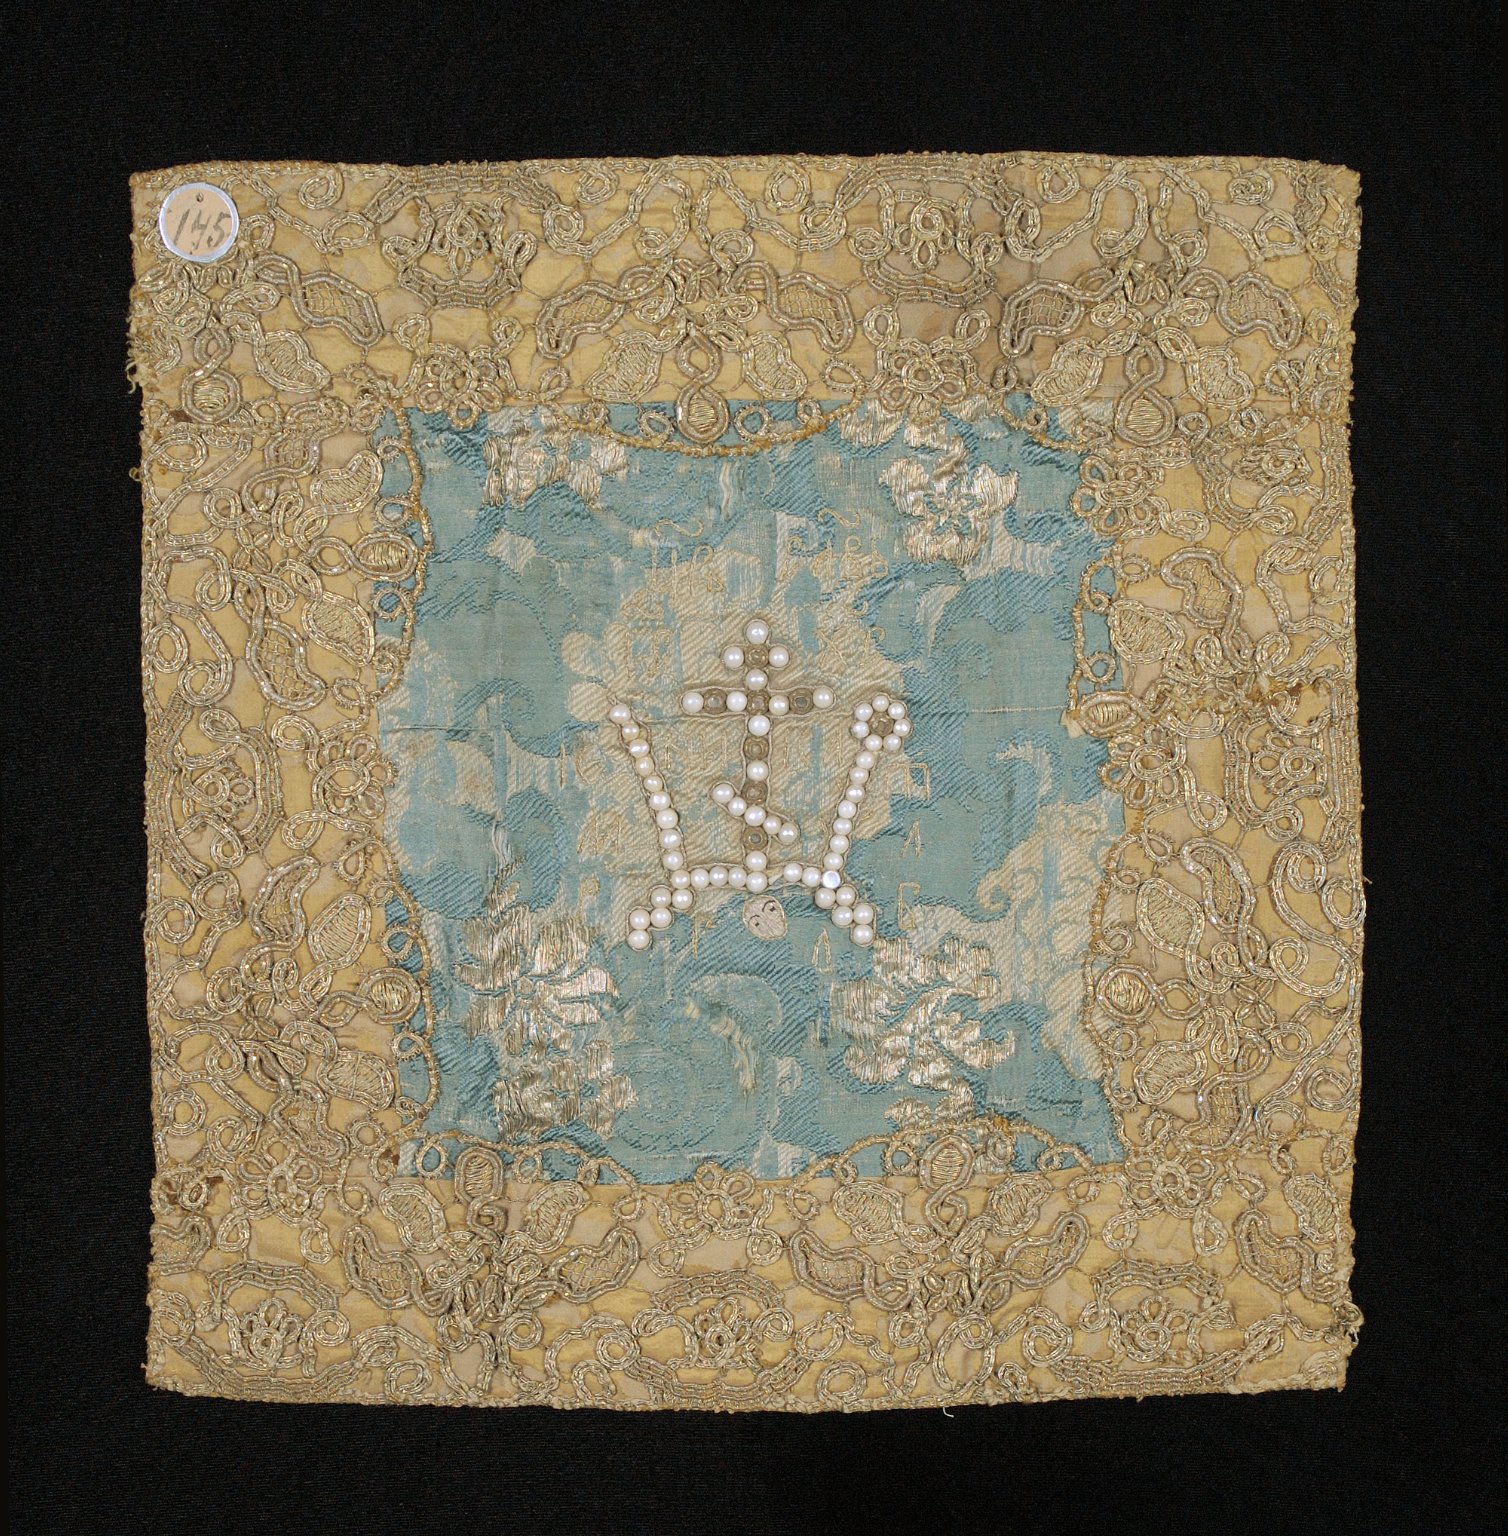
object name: chalice cover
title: Chalice veil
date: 1700-1750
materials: glass, metal, pearl, silk